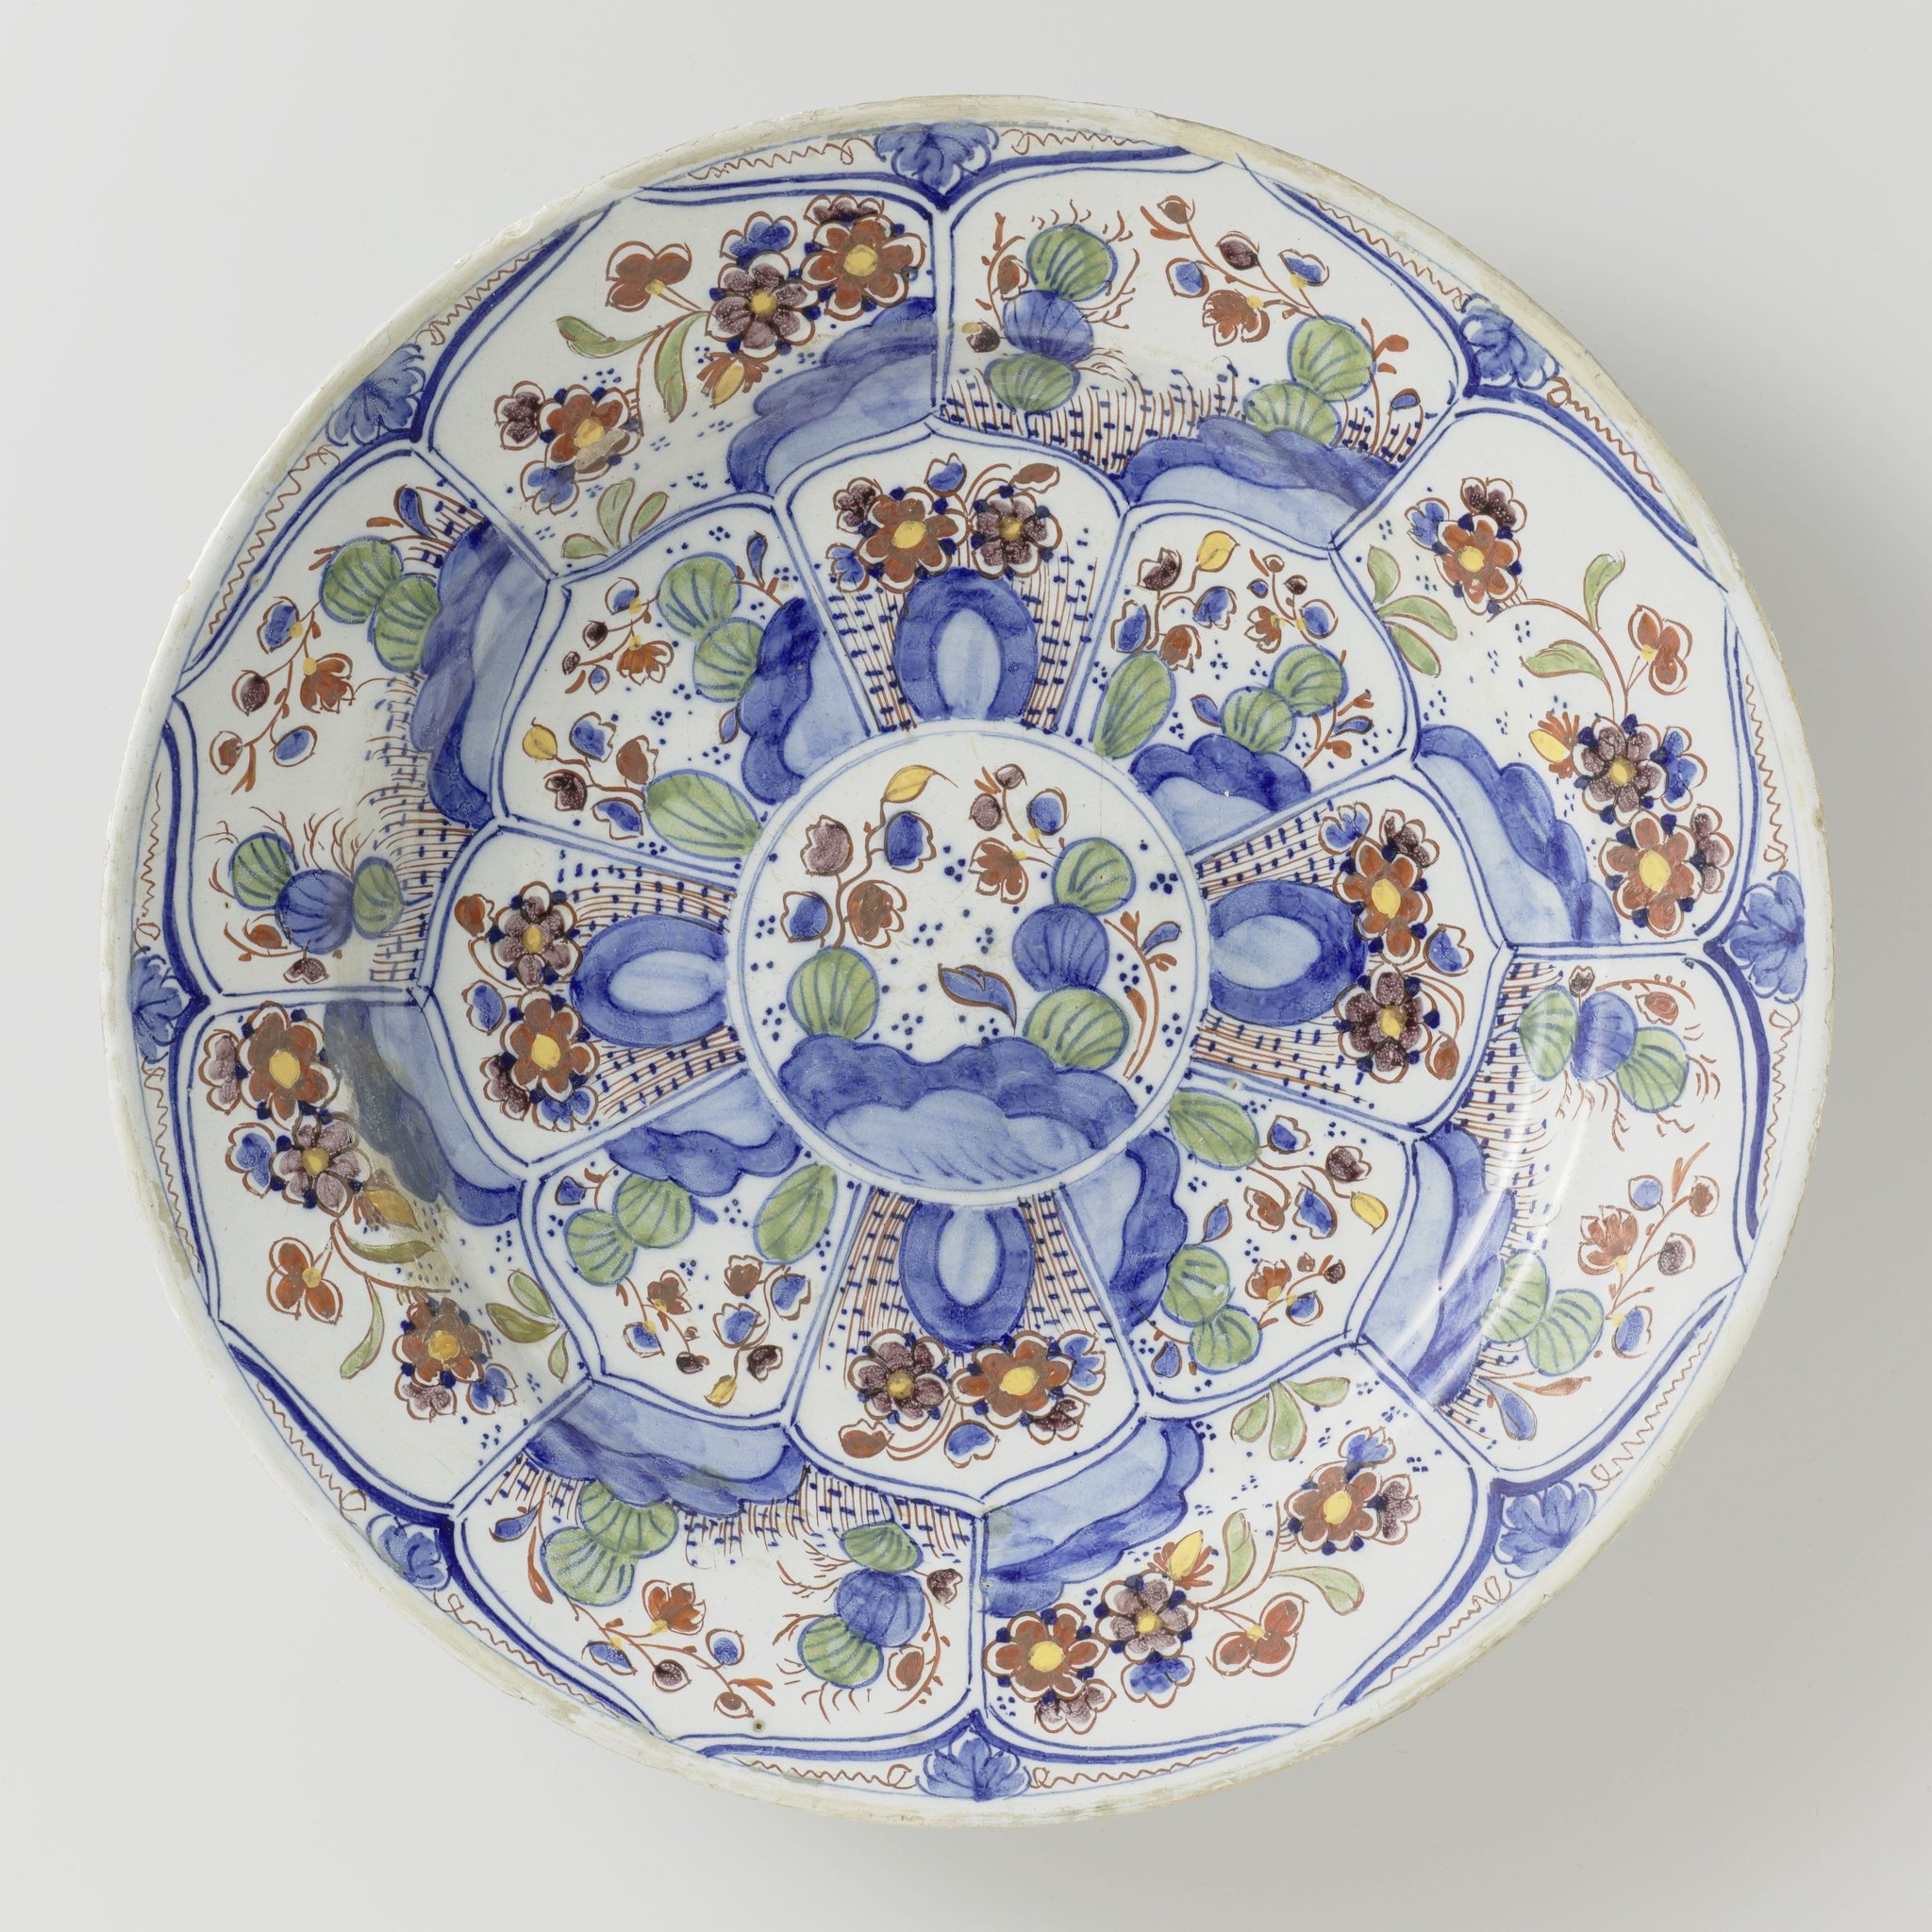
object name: platter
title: Schotel van veelkleurig beschilderde faience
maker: johannes van duijn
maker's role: plateelbakker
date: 1765-1780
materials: earthenware, glaze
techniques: painted, polychromy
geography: delft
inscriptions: mark: ‘VD(ineen)uijn/ 4’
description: Ronde schotel van veelkleurig beschilderde faience. Op het plat is een cirkel met daarbinnen planten op een grond geschilderd, daar omheen acht vakken met planten en bloemen. De rand is verdeeld in acht vakken waarbinnen planten en bloemen. De gebruikte kleuren zijn: blauw, groen, rood, paars en geel. Bij de schotel horen vijf identieke schotels met invnrs. BK-NM-13347-a, BK-NM-133347-b, BK-NM-13347-d, BK-NM-13347-e, BK-NM-13347-f. De schotel is gemerkt. De glazuur geheel losgelaten.